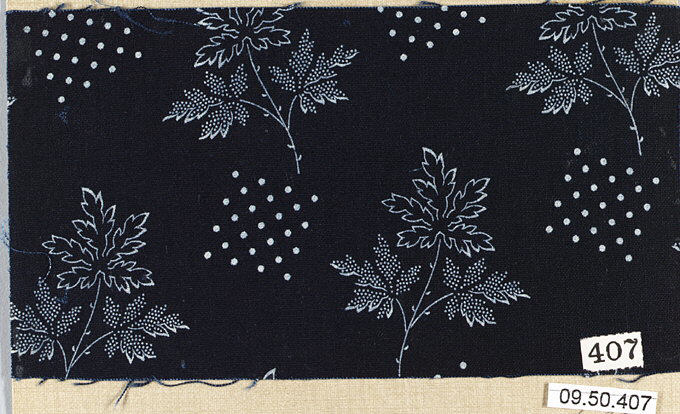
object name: piece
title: Piece (one of 116)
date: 1801-1900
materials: cotton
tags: leaves